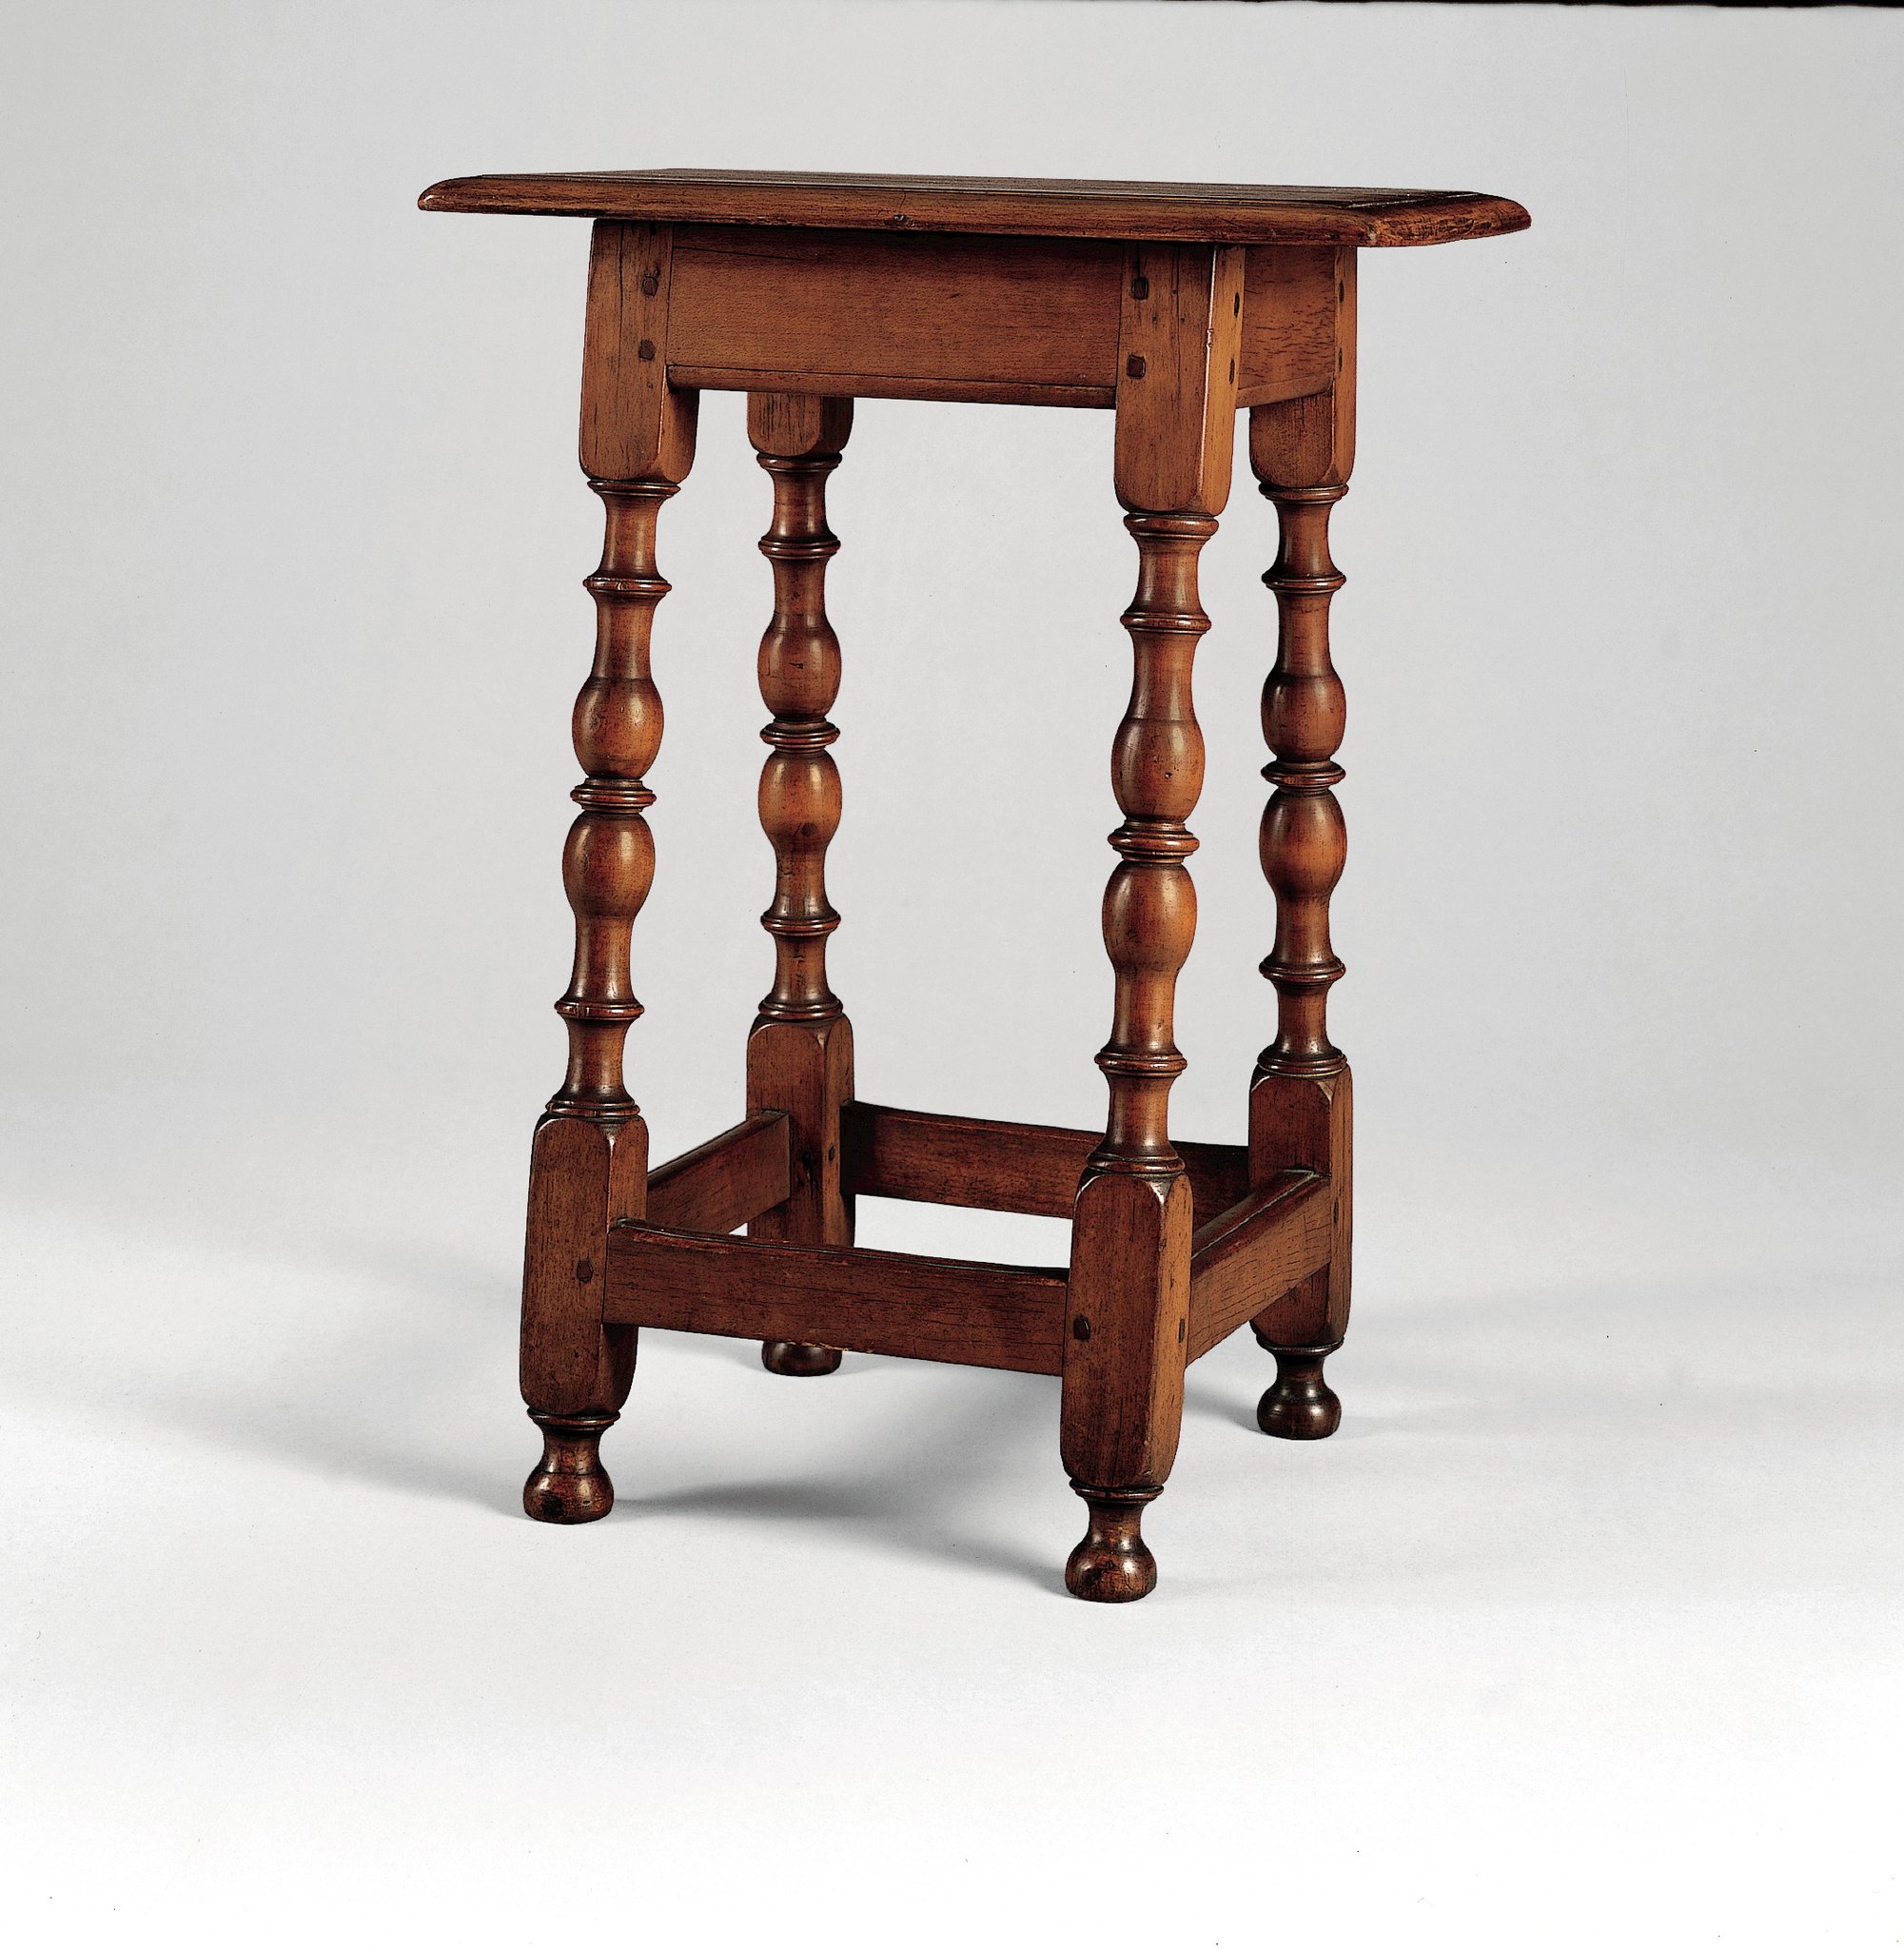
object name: joint stool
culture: american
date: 1700-1725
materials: wood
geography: united states